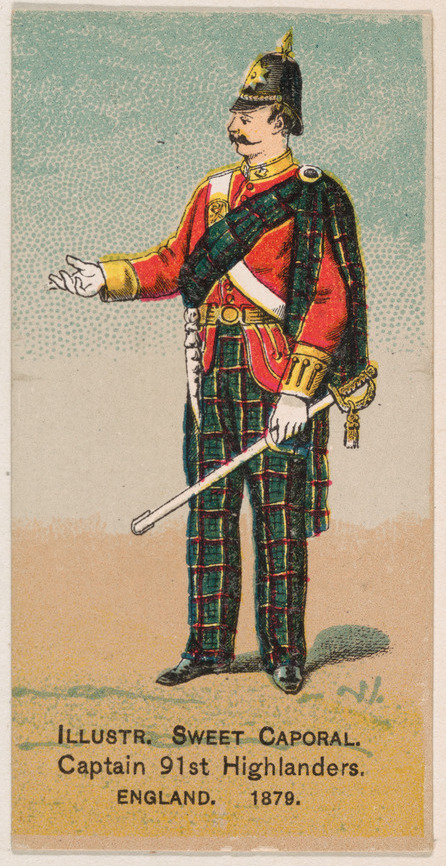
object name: print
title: Captain, 91st Highlanders, England, 1879, from the Military Series (N224) issued by Kinney Tobacco Company to promote Sweet Caporal Cigarettes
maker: kinney brothers tobacco company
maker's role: publisher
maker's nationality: american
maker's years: 1869-2011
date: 1888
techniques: color lithograph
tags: military,men,profiles